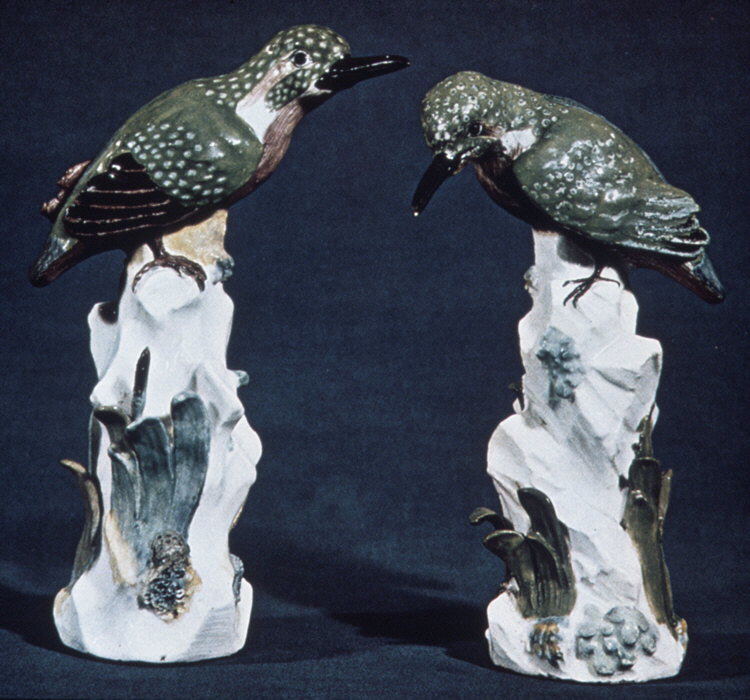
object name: figure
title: Kingfisher (one of a pair)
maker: meissen manufactory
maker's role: manufactory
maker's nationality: german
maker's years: 1710-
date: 1735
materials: hard paste porcelain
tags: birds